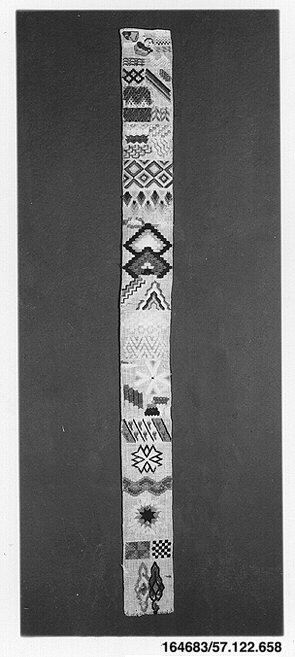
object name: sampler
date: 1801-1900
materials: canvas, wool